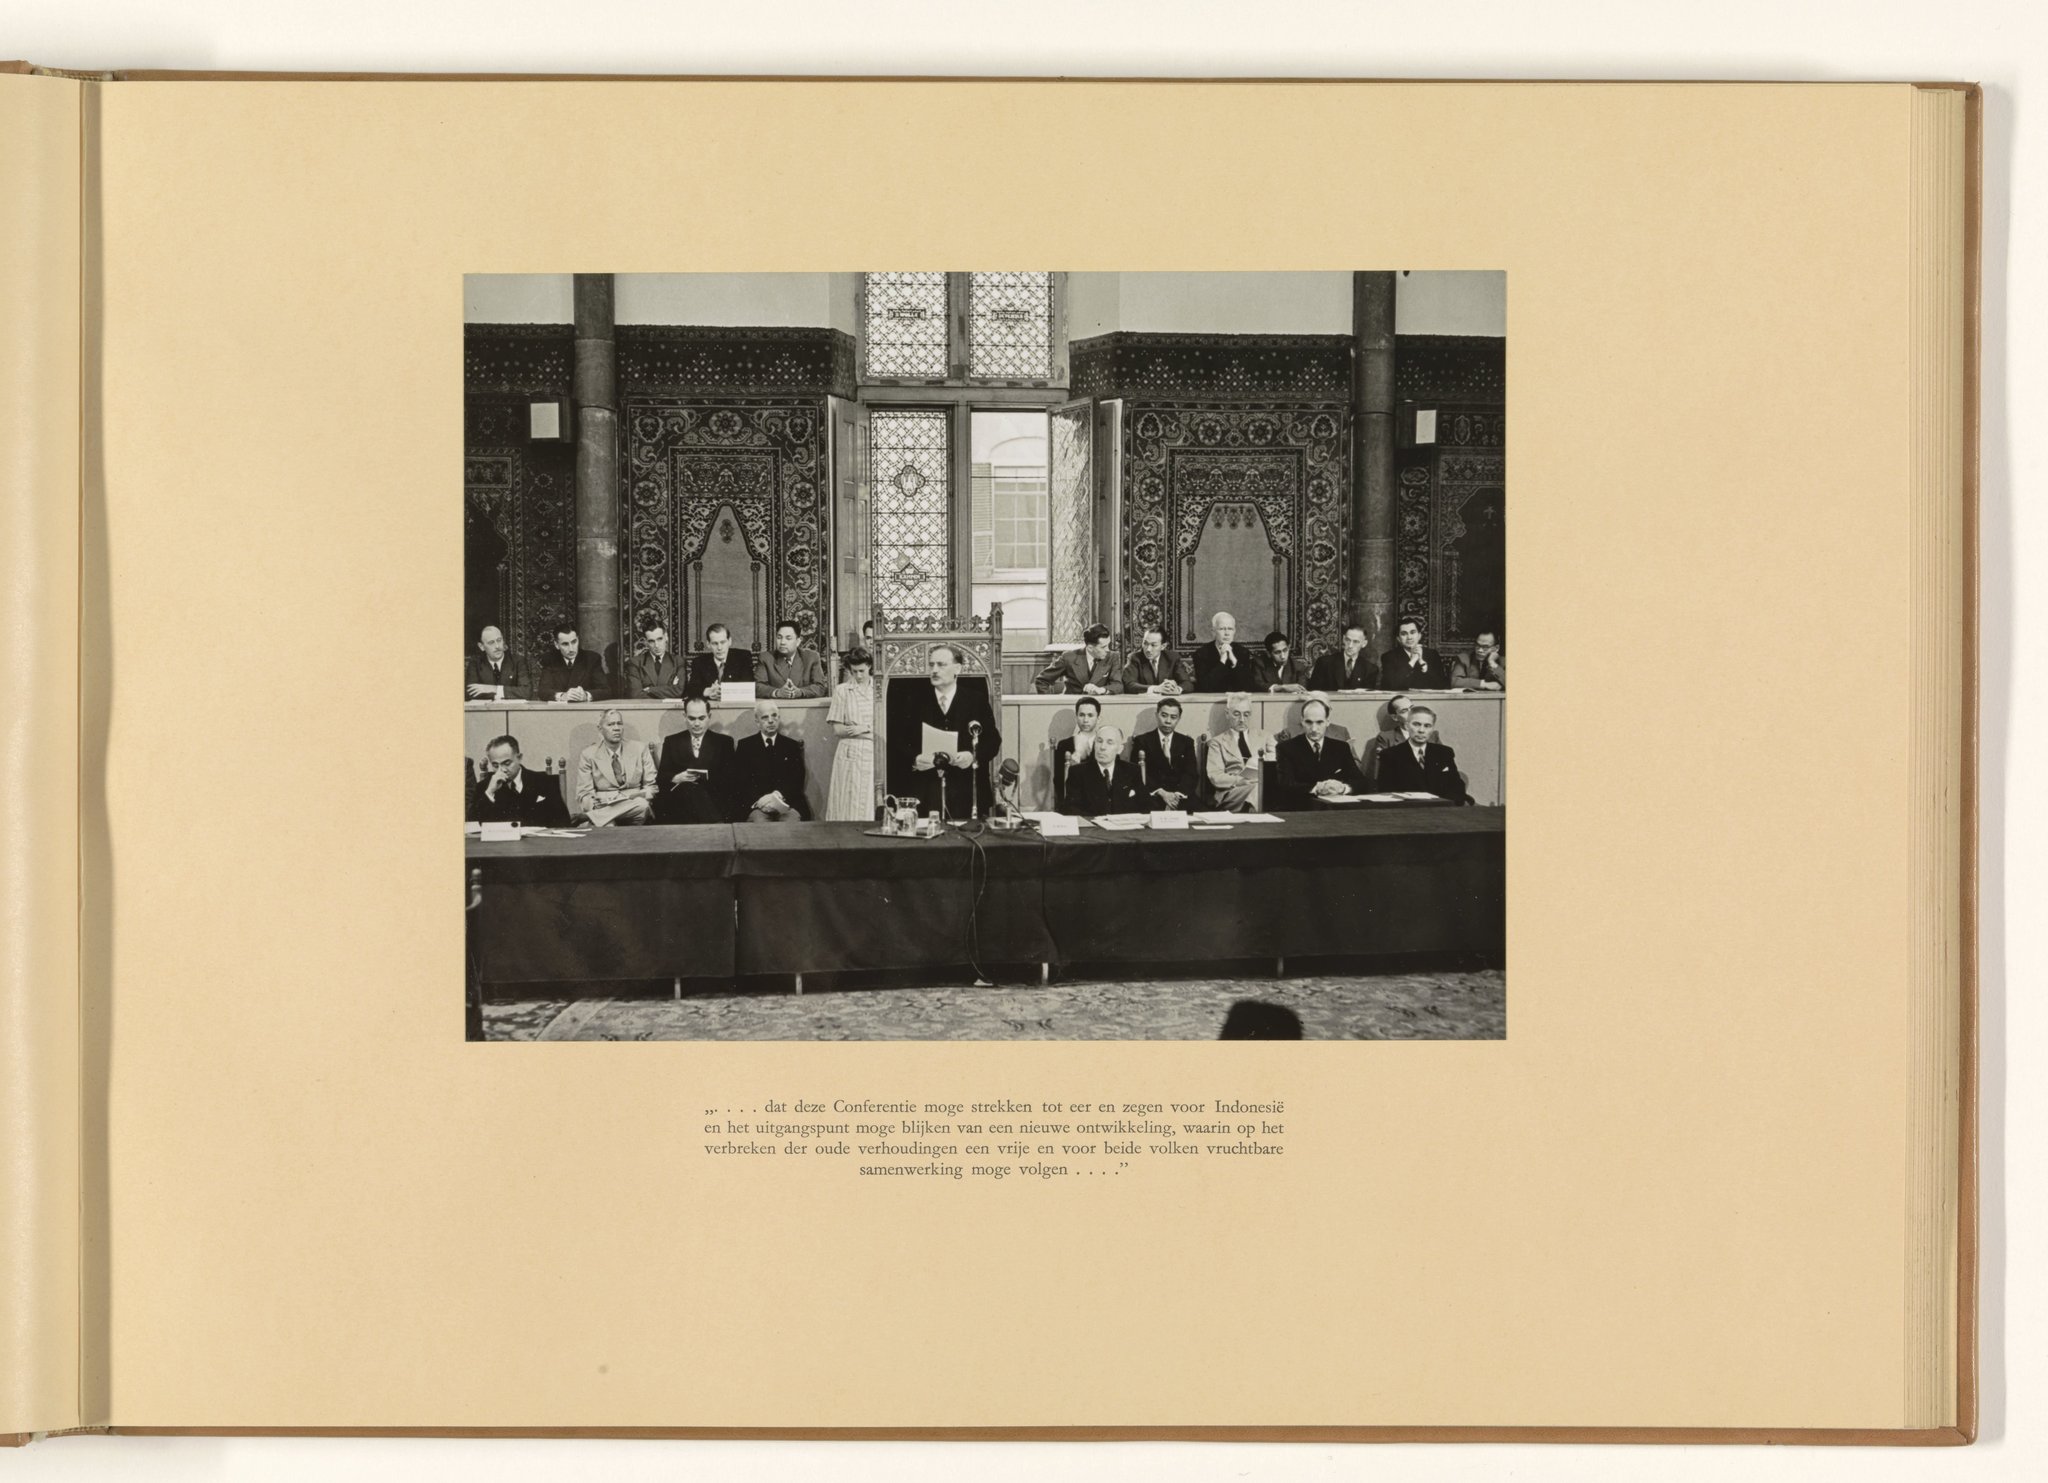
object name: photograph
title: " .... dat deze Conferentie moge strekken tot eer en zegen voor Indonesië en het uitgangspunt moge blijken van een nieuwe ontwikkeling, waarin op het verbreken der oude verhoudingen een vrije en voor beide volken vruchtbare samenwerking moge volgen .... "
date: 1949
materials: paper, photographic support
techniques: gelatin silver print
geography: the hague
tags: amsterdam, willem drees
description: Premier Willem Drees spreekt de aanwezigen toe op de openingszitting van de conferentie in de Ridderzaal op 23 augustus. Foto in het fotoalbum met 37 foto's van de rondetafelconferentie gehouden tussen 23 augustus en 2 november in Den Haag in 1949 tussen vertegenwoordigers van Nederland, de Republiek Indonesië en de Bijeenkomst Federaal Overleg. Het exemplaar aangeboden aan premier Willem Drees.